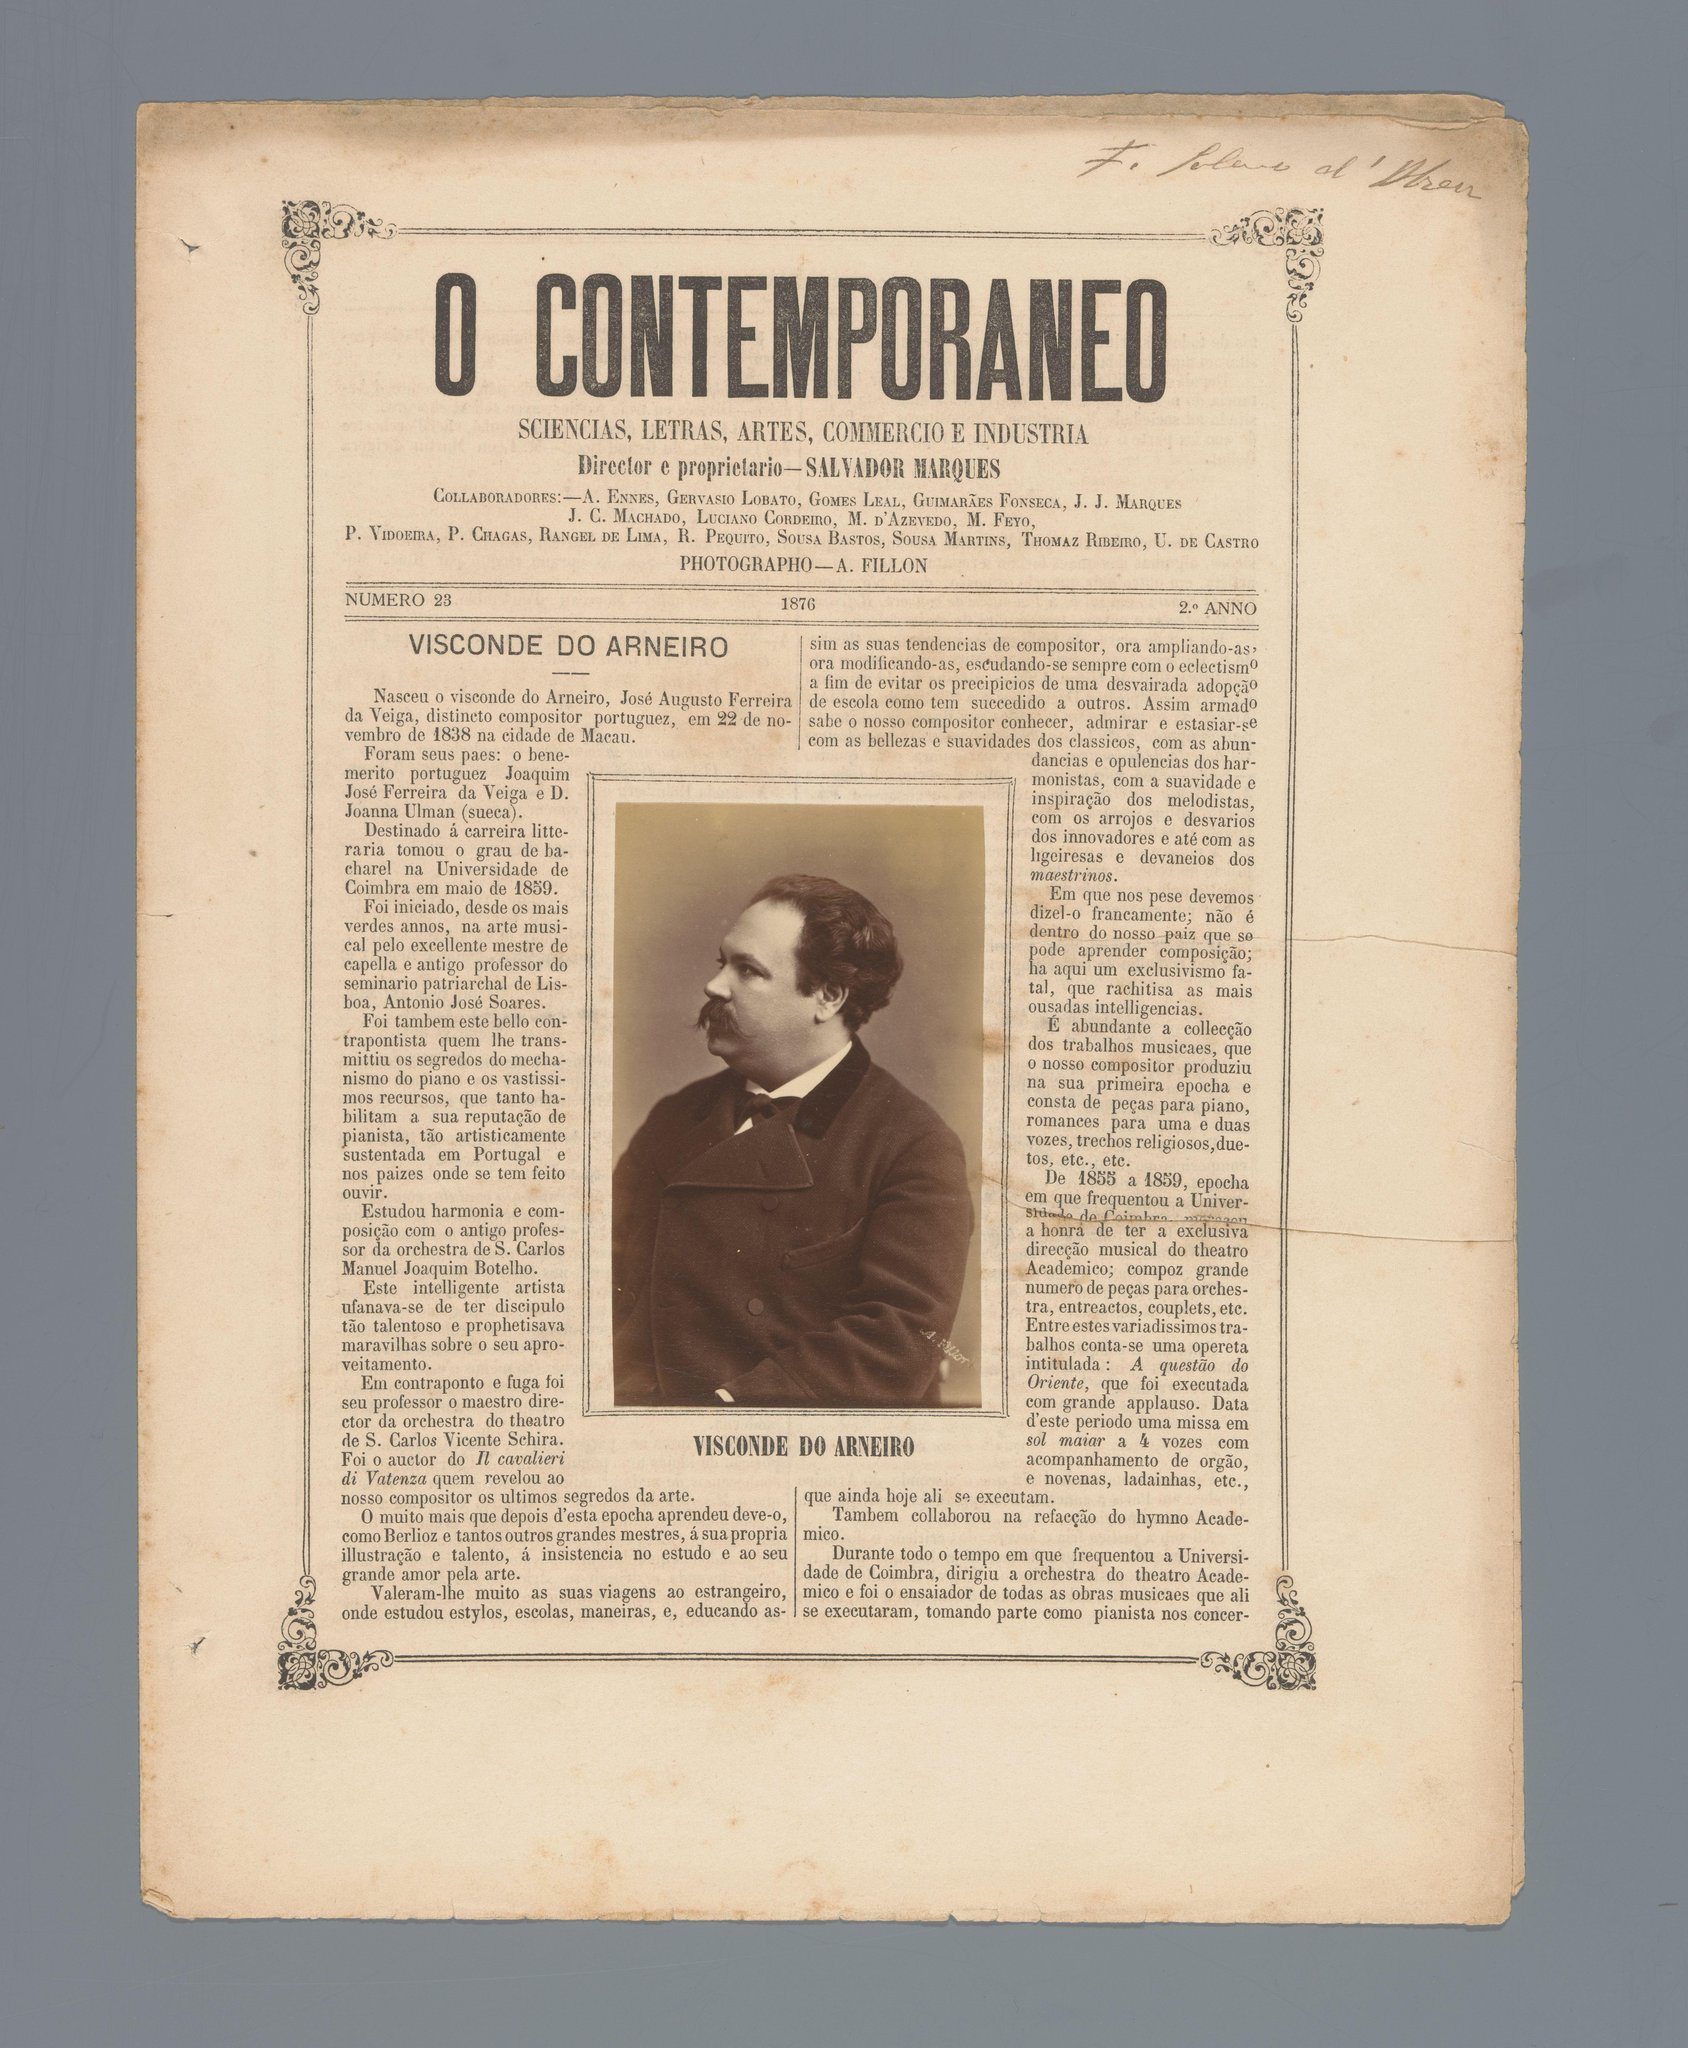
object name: photograph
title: O contemporaneo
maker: alfred fillon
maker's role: fotograaf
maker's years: 1825-1881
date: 1871-1876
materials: paper, photographic support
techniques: albumen print, printing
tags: historical persons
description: Op de voorpagina bevindt zich een portret van José Augusto Ferreira Veiga.